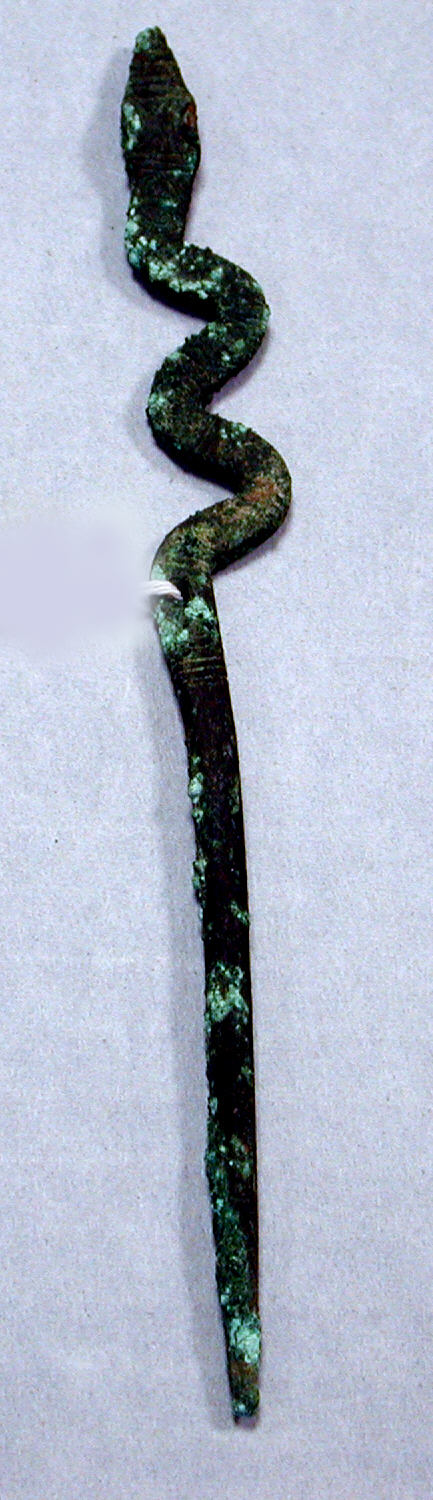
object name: pin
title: Copper Pin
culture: peruvian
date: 1501-1600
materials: copper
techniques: casting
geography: peru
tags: snakes